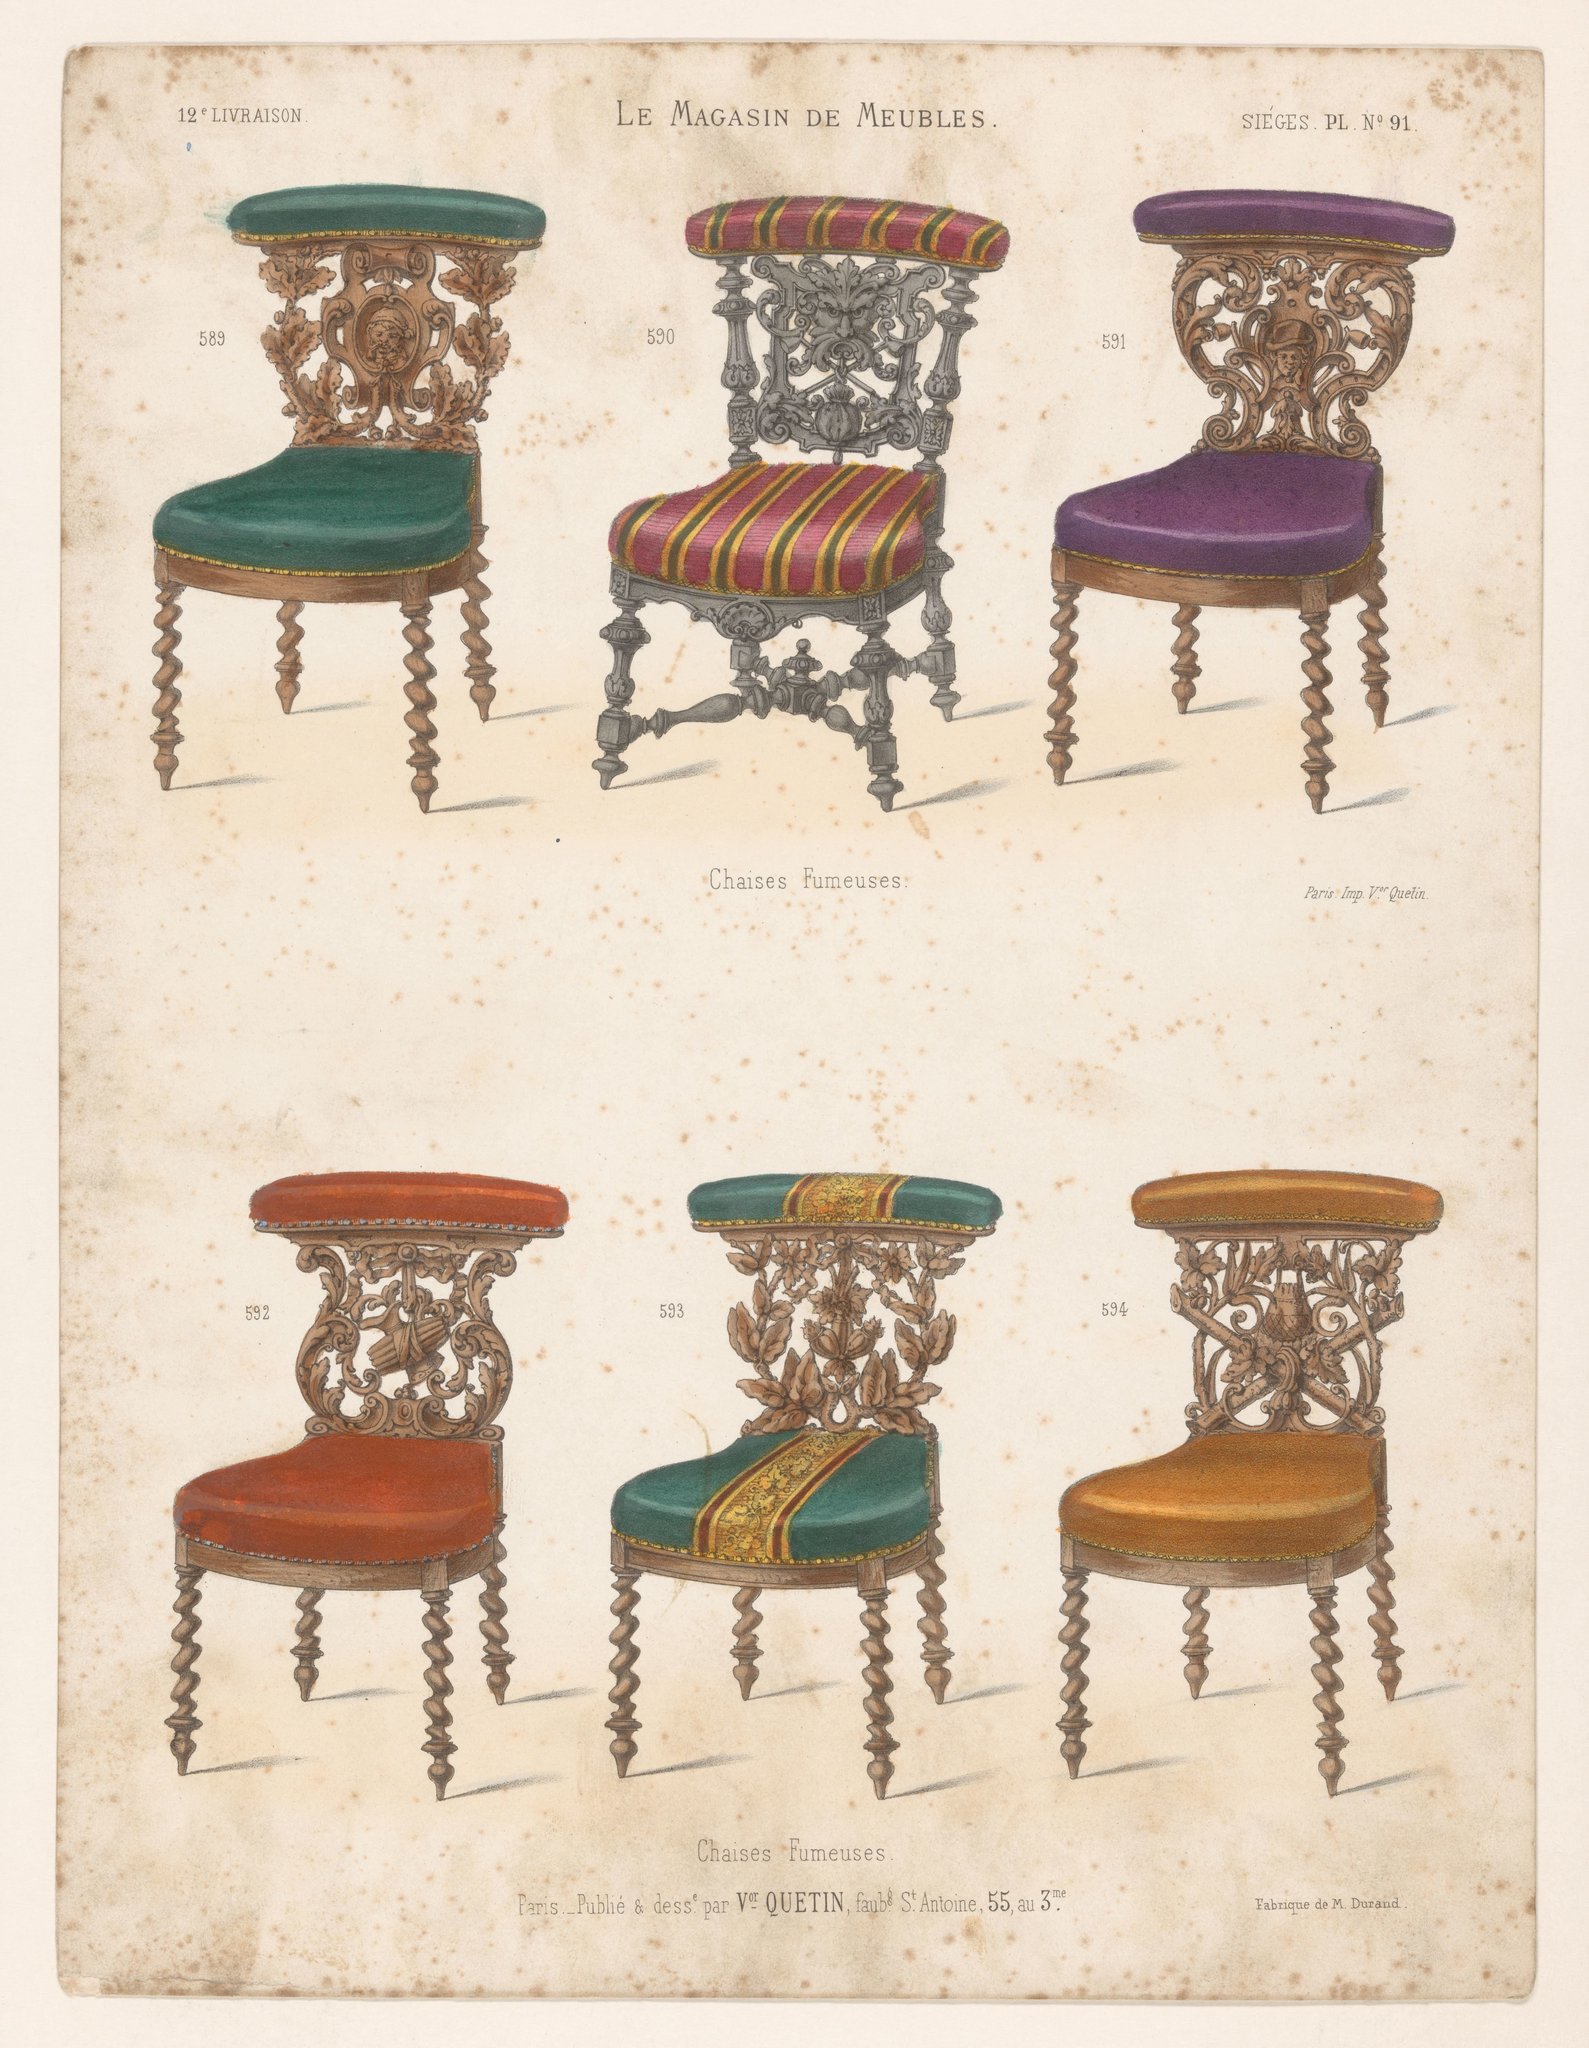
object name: print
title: Zes rookstoelen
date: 1832-1877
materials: paper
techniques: hand coloring, lithograph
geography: paris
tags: seating furniture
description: Zes rookstoelen. Prent uit 12e Livraison.